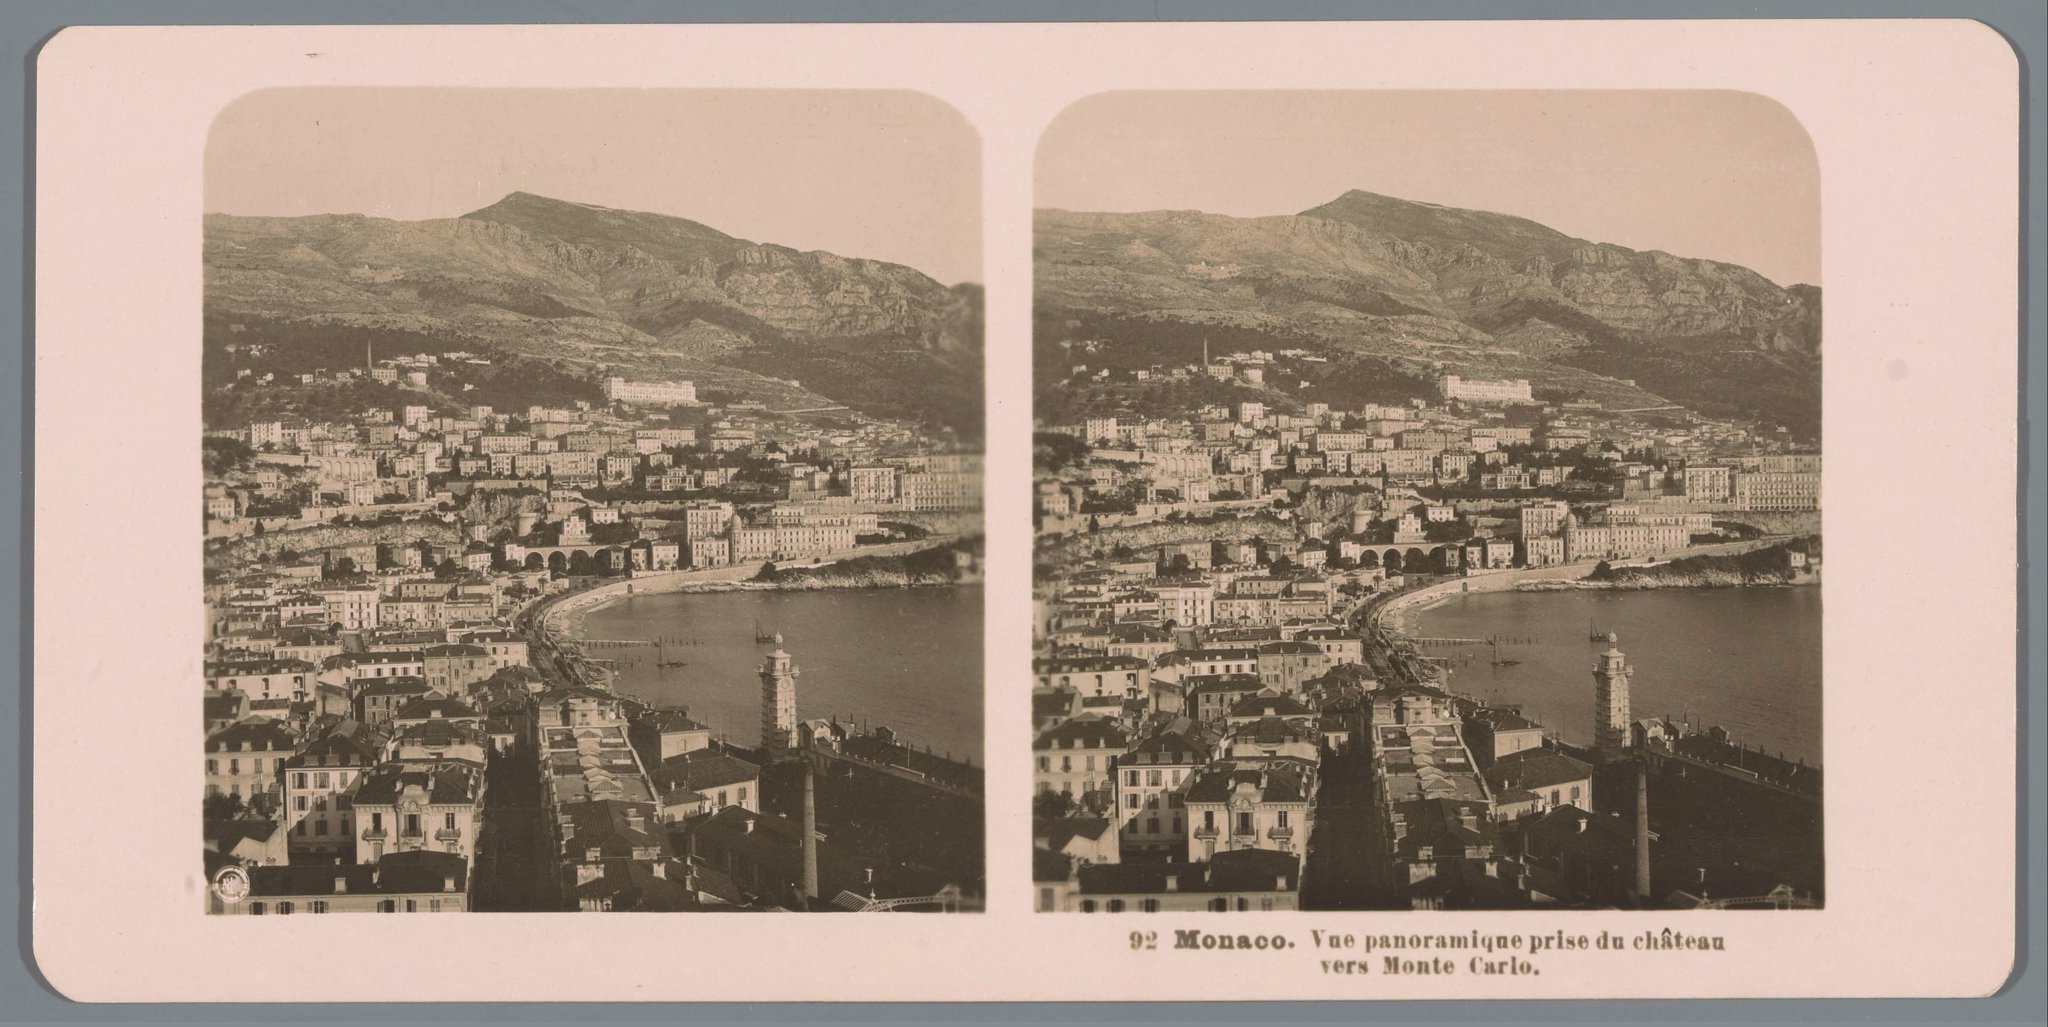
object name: stereograph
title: Gezicht op Monaco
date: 1900-1910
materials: cardboard, photographic support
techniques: gelatin silver print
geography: monaco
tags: city-view in general; 'veduta'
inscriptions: inscription: ‘NPG’, number: ‘92’